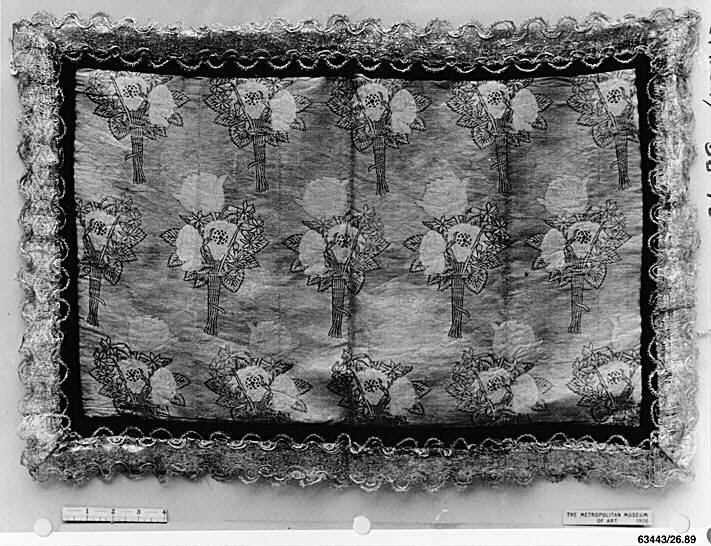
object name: panel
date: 1601-1700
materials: metal thread, silk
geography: iran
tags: flowers